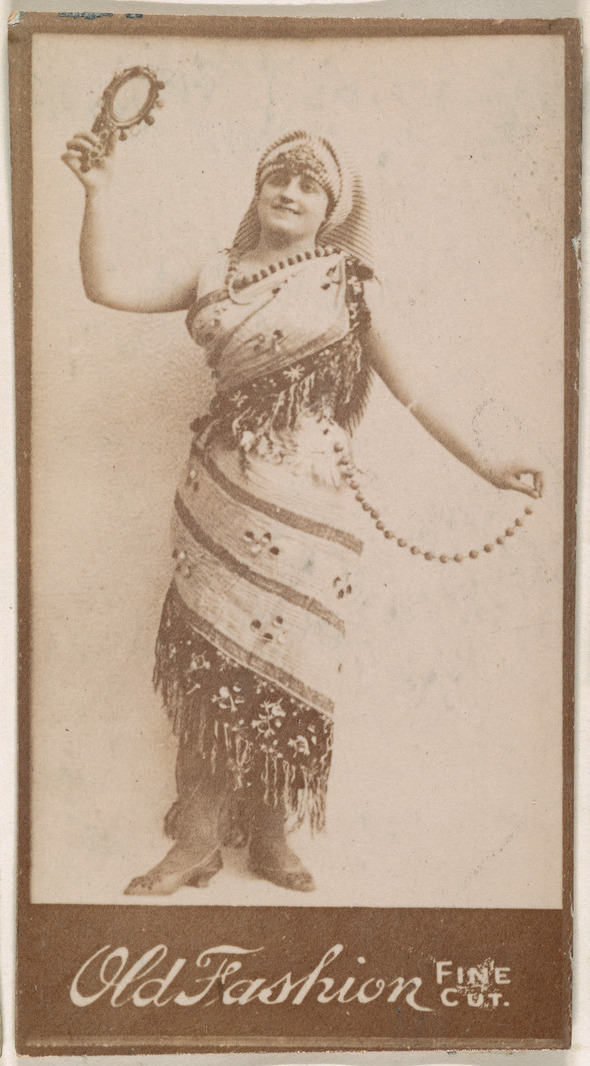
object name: photograph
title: Actress holding hand-mirror aloft, from the Actresses series (N664) promoting Old Fashion Fine Cut Tobacco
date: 1888-1890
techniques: albumen silver print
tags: portraits,women,actresses,mirrors